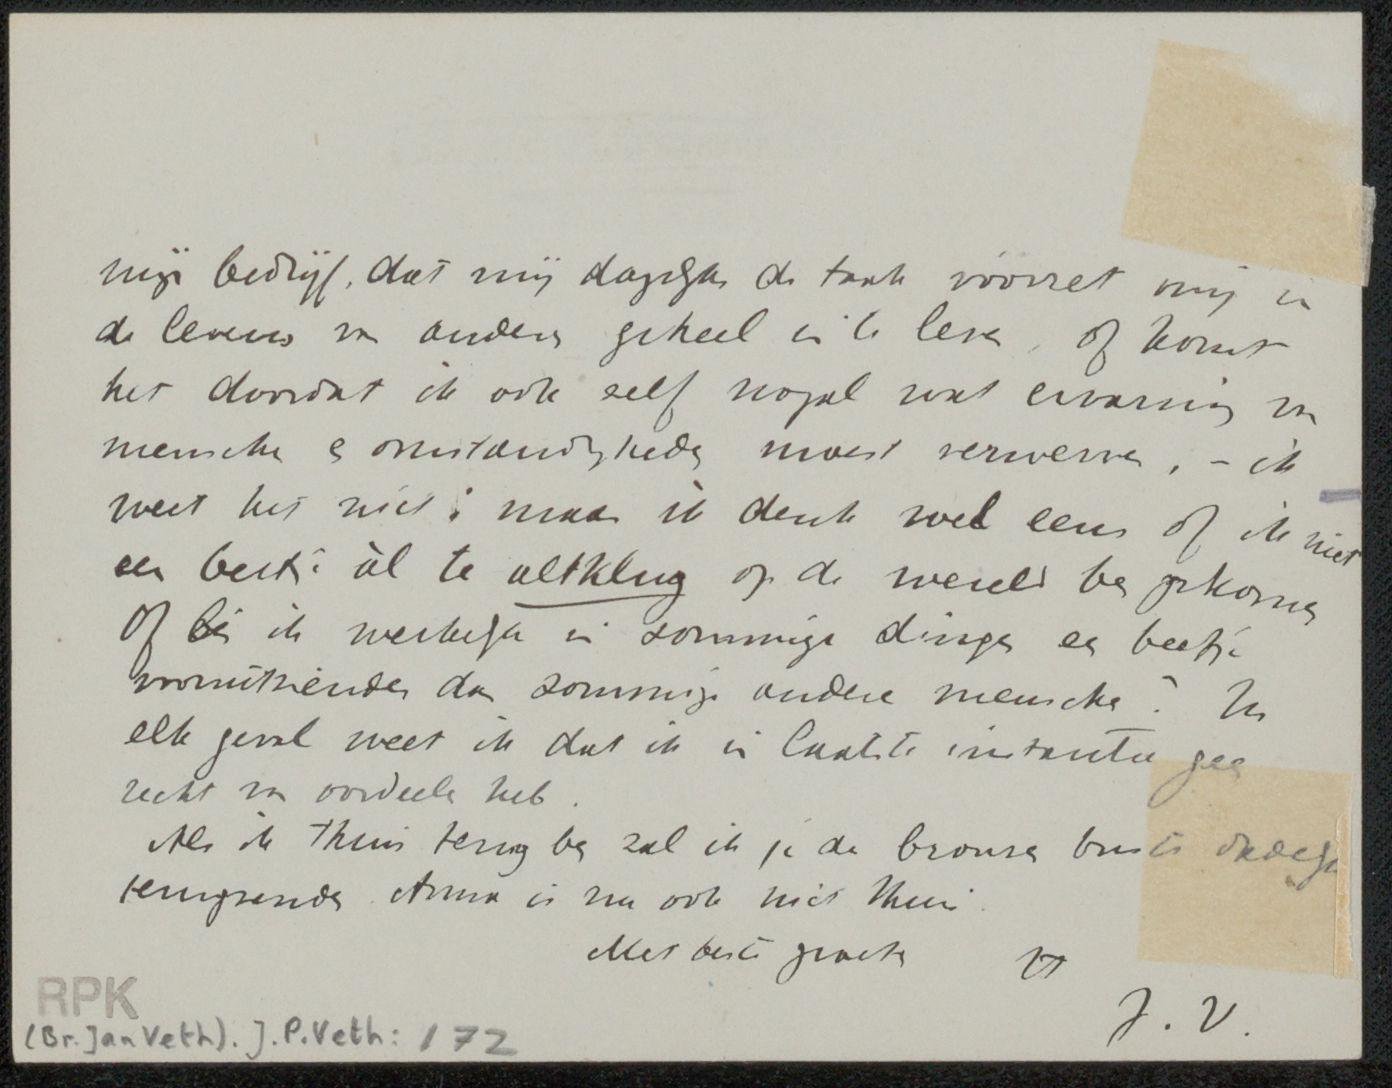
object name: letter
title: Brief aan Etha Fles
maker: jan veth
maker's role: designer, draughtsman, painter, print maker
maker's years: 1864-1925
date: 1901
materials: cardboard, ink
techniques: pen, printing, writing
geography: blankenese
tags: utrecht, etha fles, sculpture, historical persons (portraits and scenes from the life)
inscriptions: collector's mark: ‘RPK’